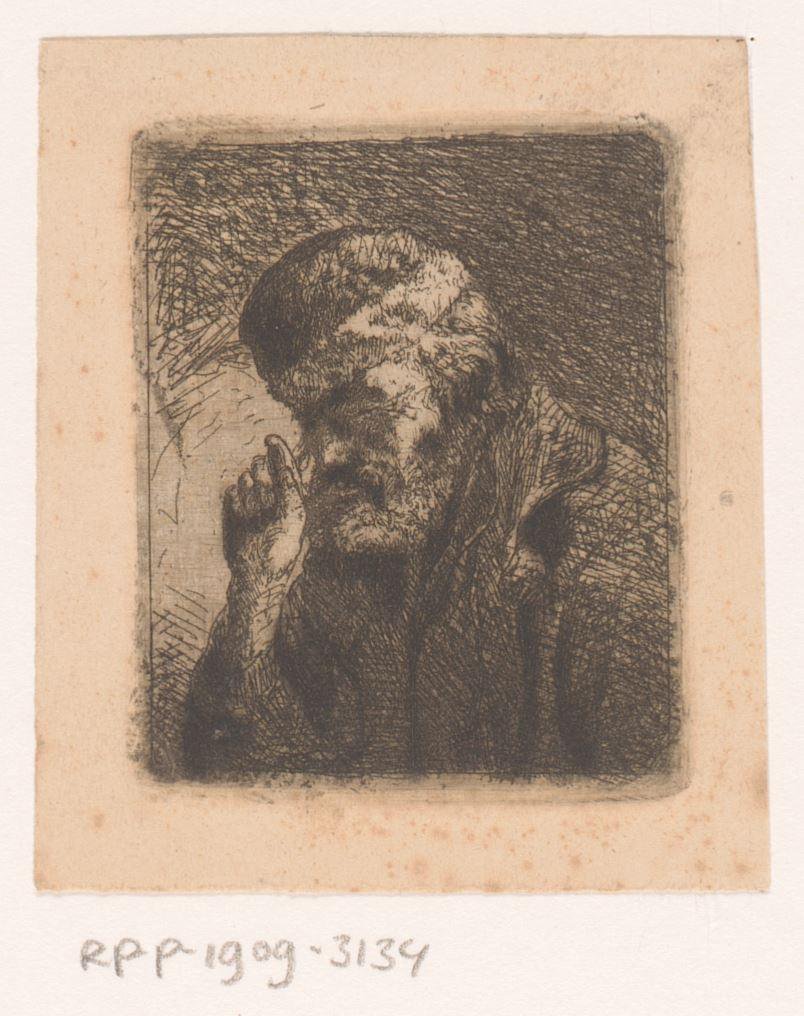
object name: print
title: Oude man met hand bij zijn neus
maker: florent nicolas crabeels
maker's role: print maker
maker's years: 1829-1896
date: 1839-1879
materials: paper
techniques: drypoint, etching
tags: old man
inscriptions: collector's mark: Lugt 1485, collector's mark: Lugt 2228